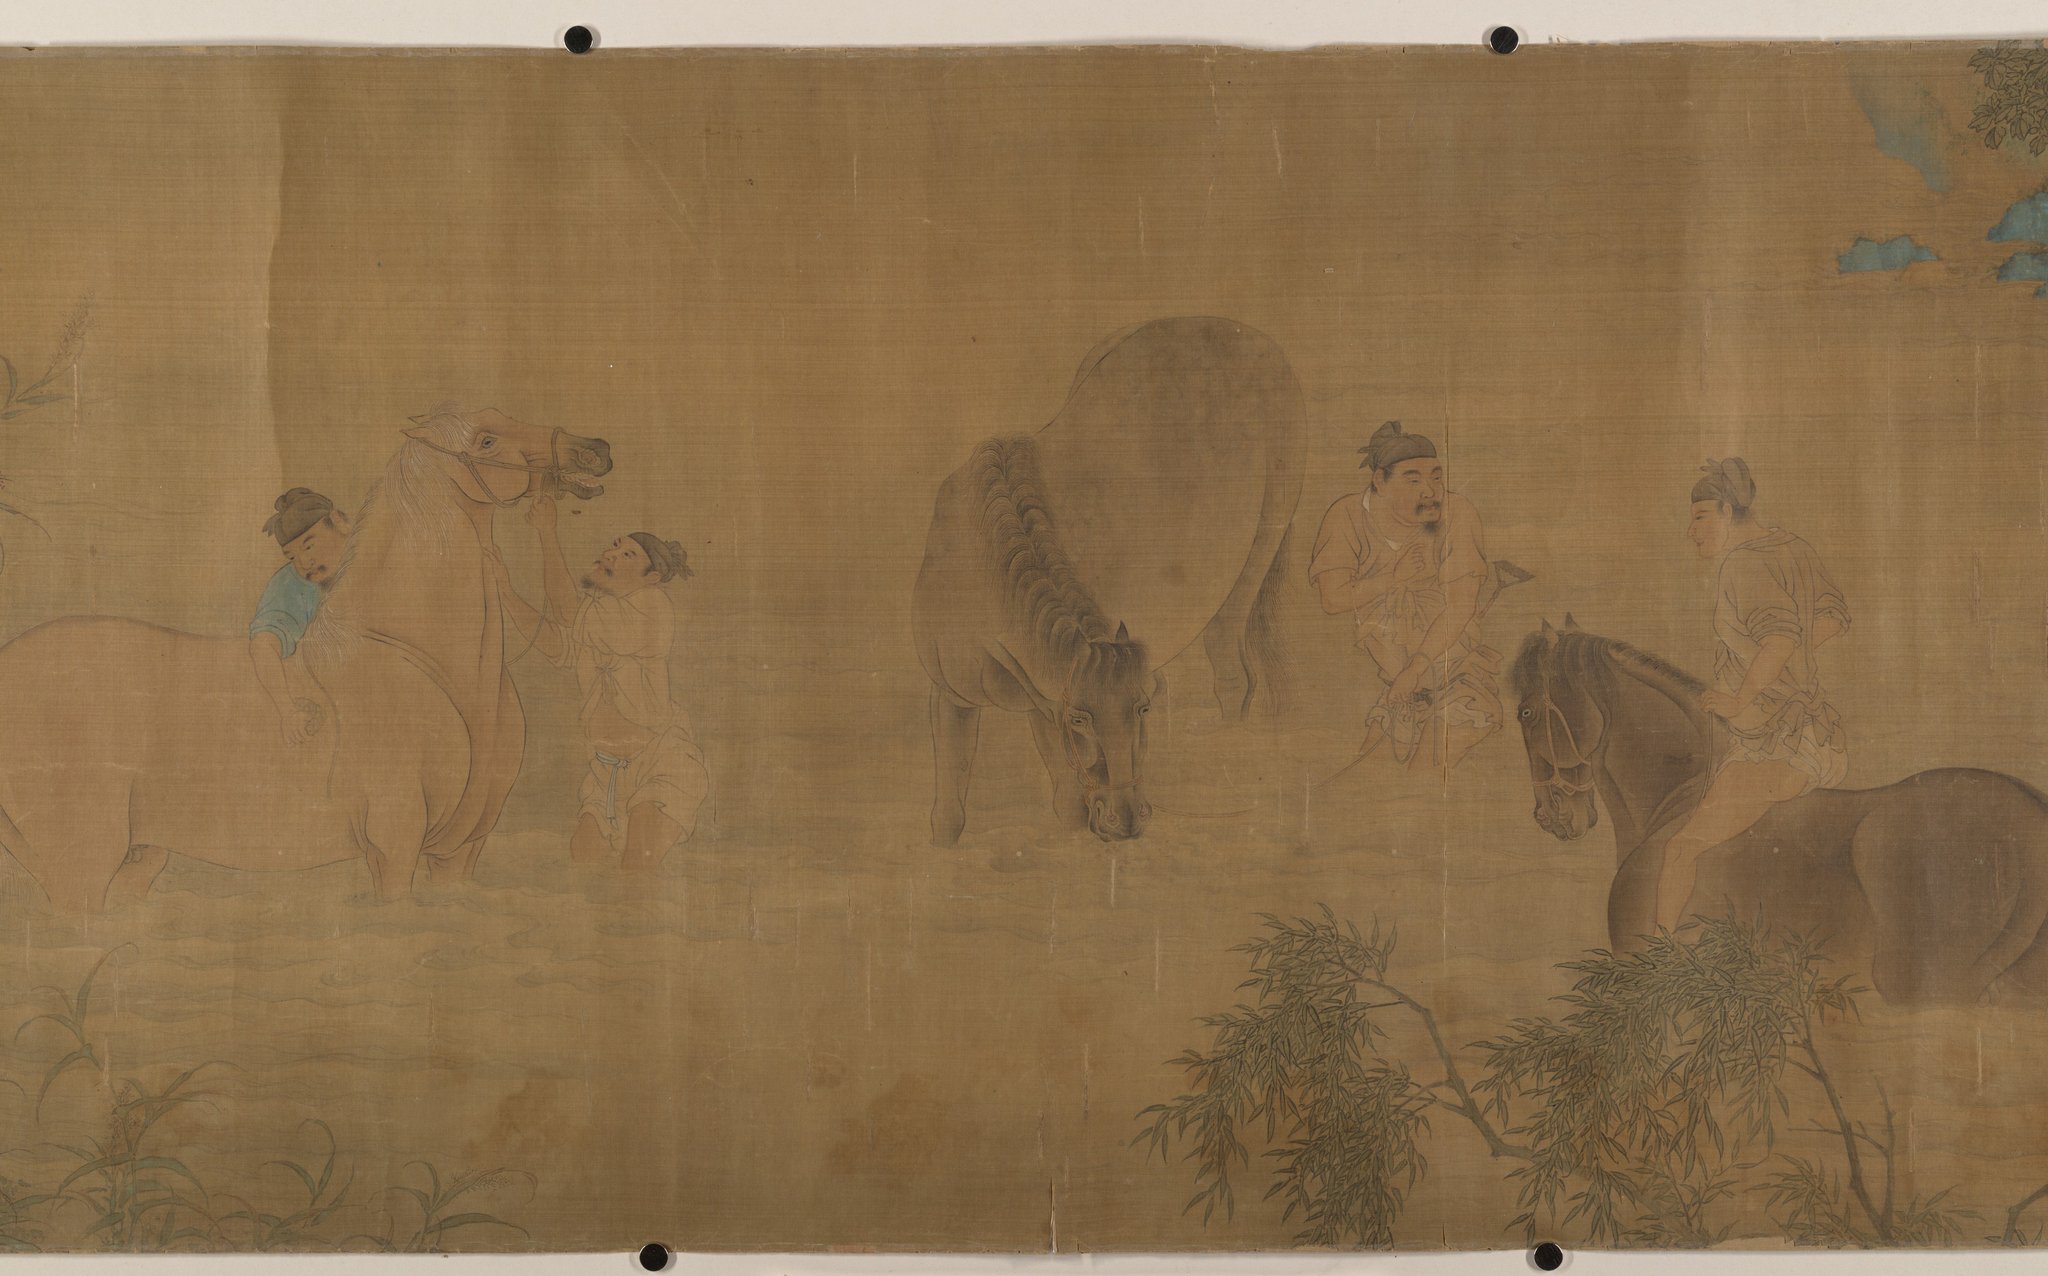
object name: handscroll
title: Washing Horses in a River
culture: chinese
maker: unidentified artist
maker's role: artist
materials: ink, silk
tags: men,horses